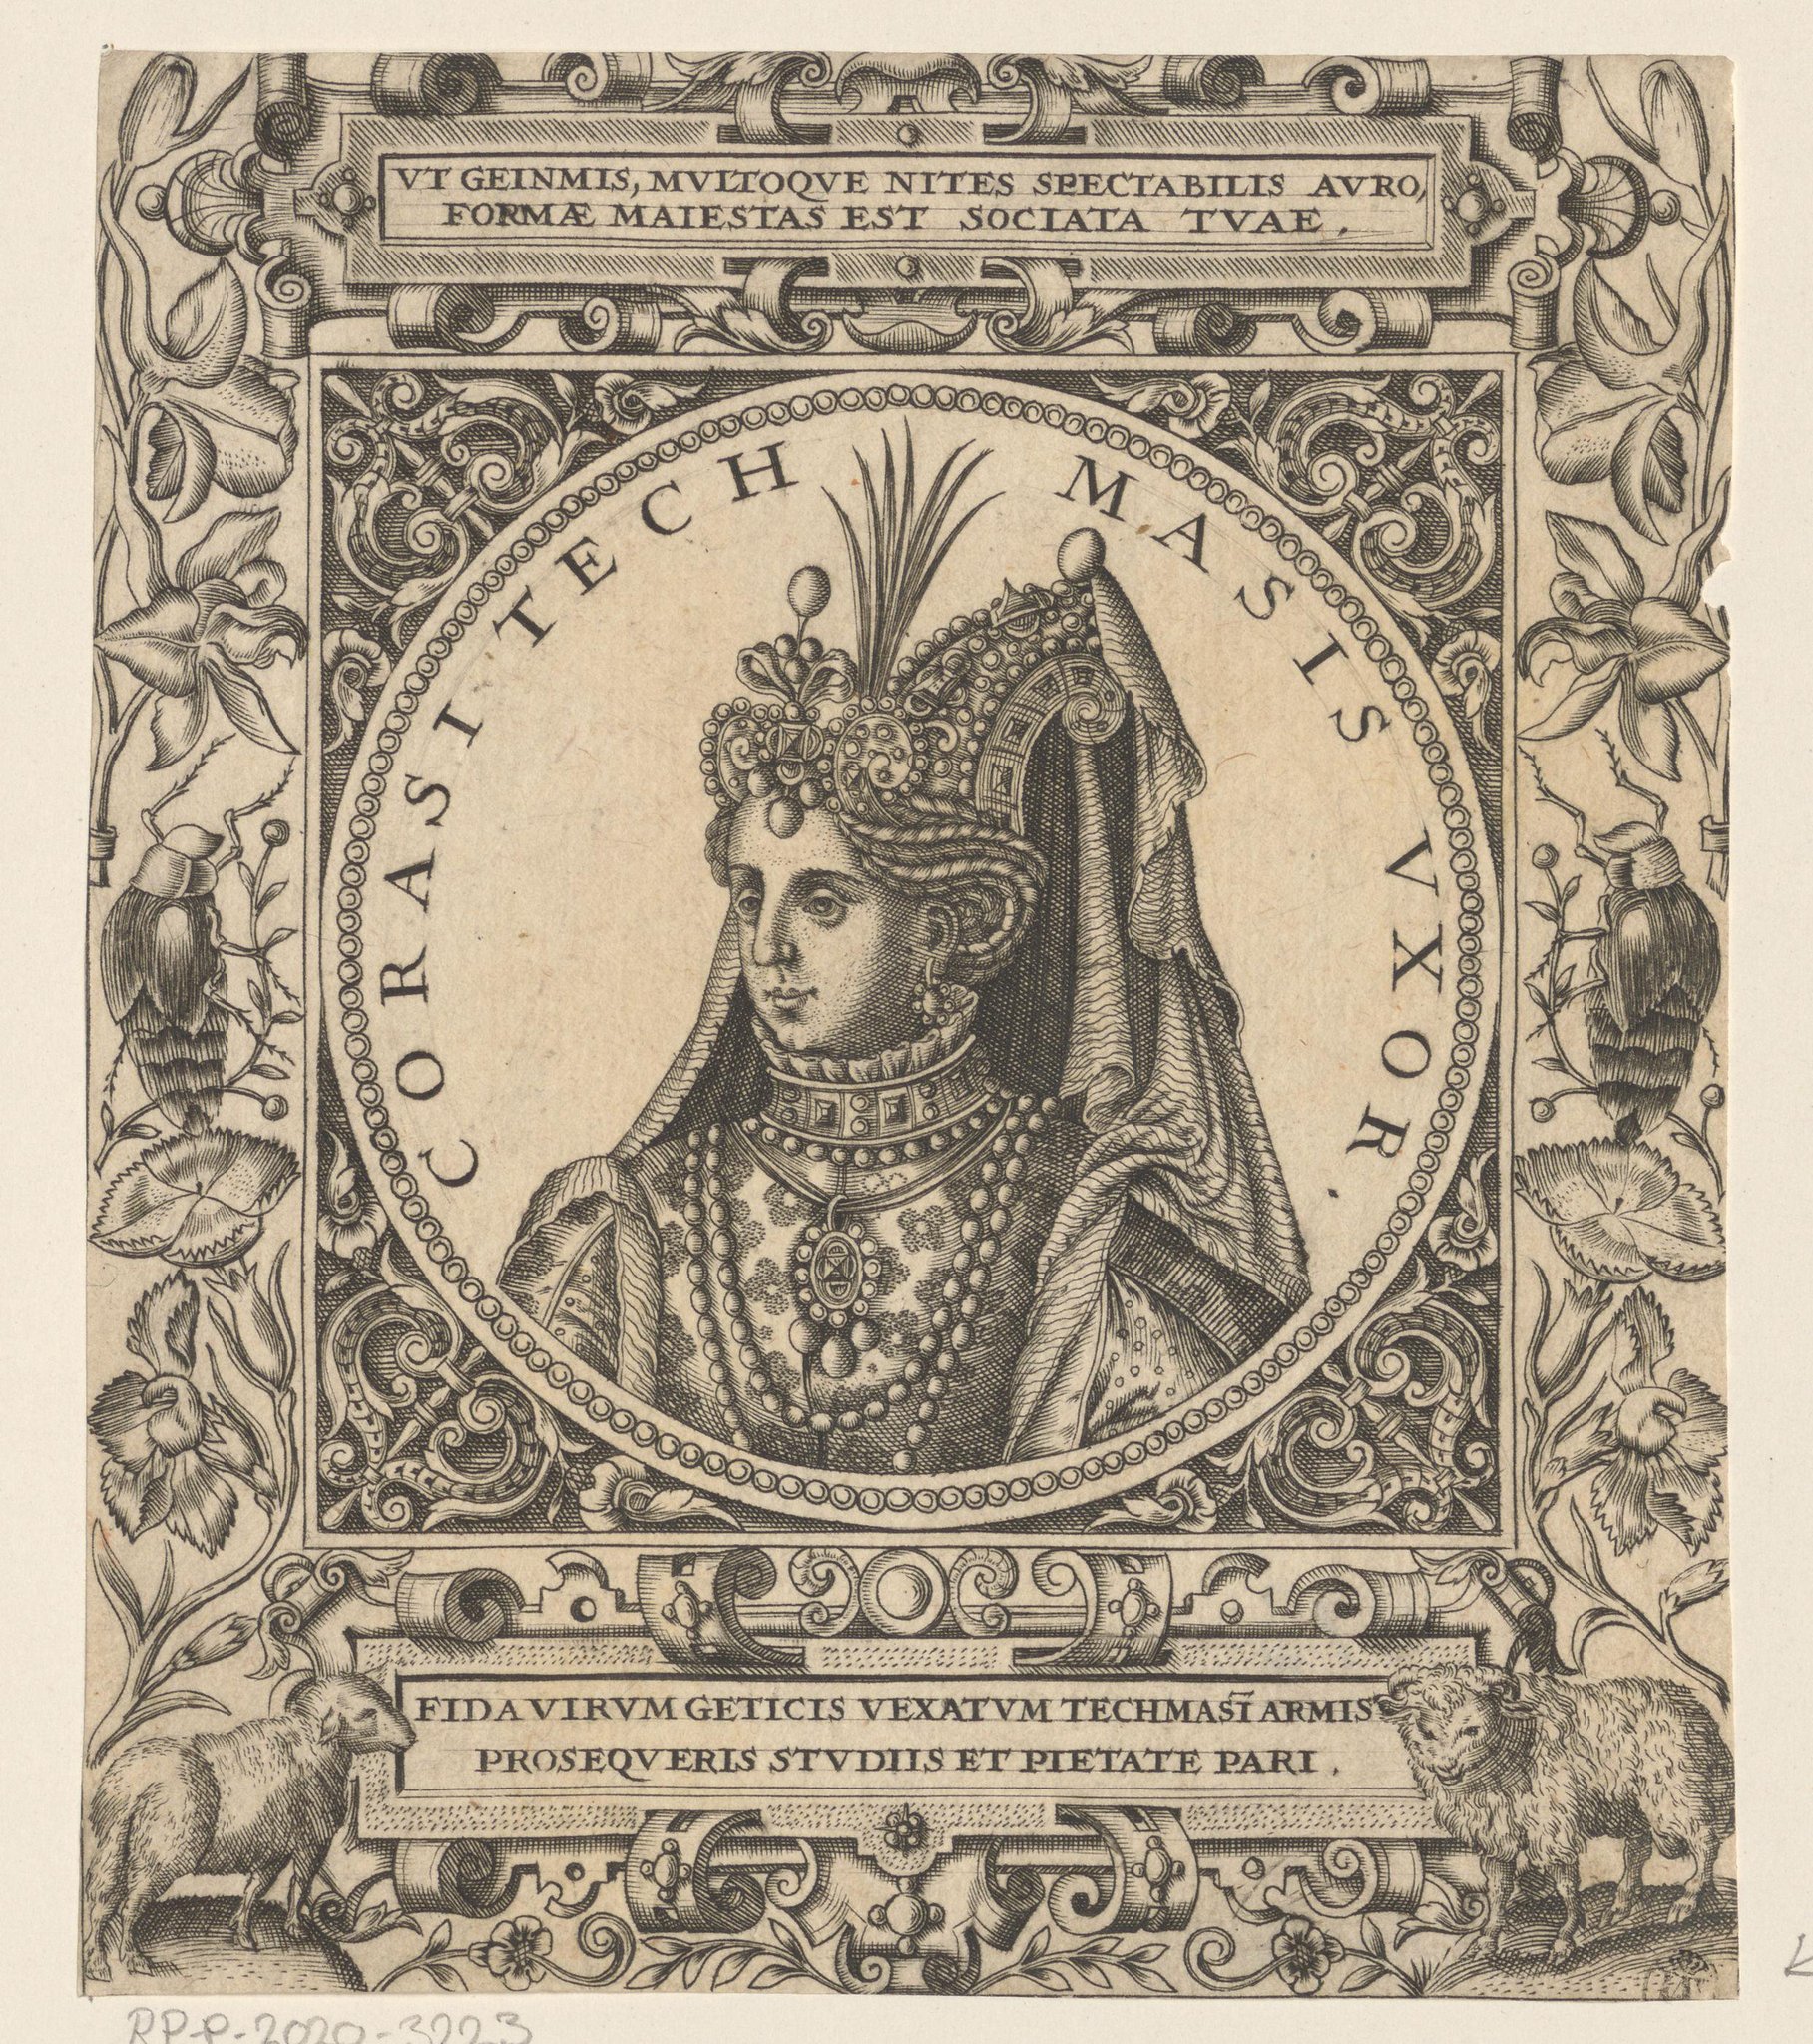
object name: print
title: Portret van Sultan-Agha Khanum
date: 1596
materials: paper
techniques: engraving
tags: historical persons - bb - woman, ruler, sovereign - bb - female ruler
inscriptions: collector's mark: Lugt 971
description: Prent mogelijk uit: Boissard, Jean Jacques. Vitae et icones svltanorvm tvrcicorum, principvm persarvm aliorumq illustrium heroum heroinarumq ab Osmane usq ad Mahometem II. Frankfurt am Main: Theodor de Bry, 1596.